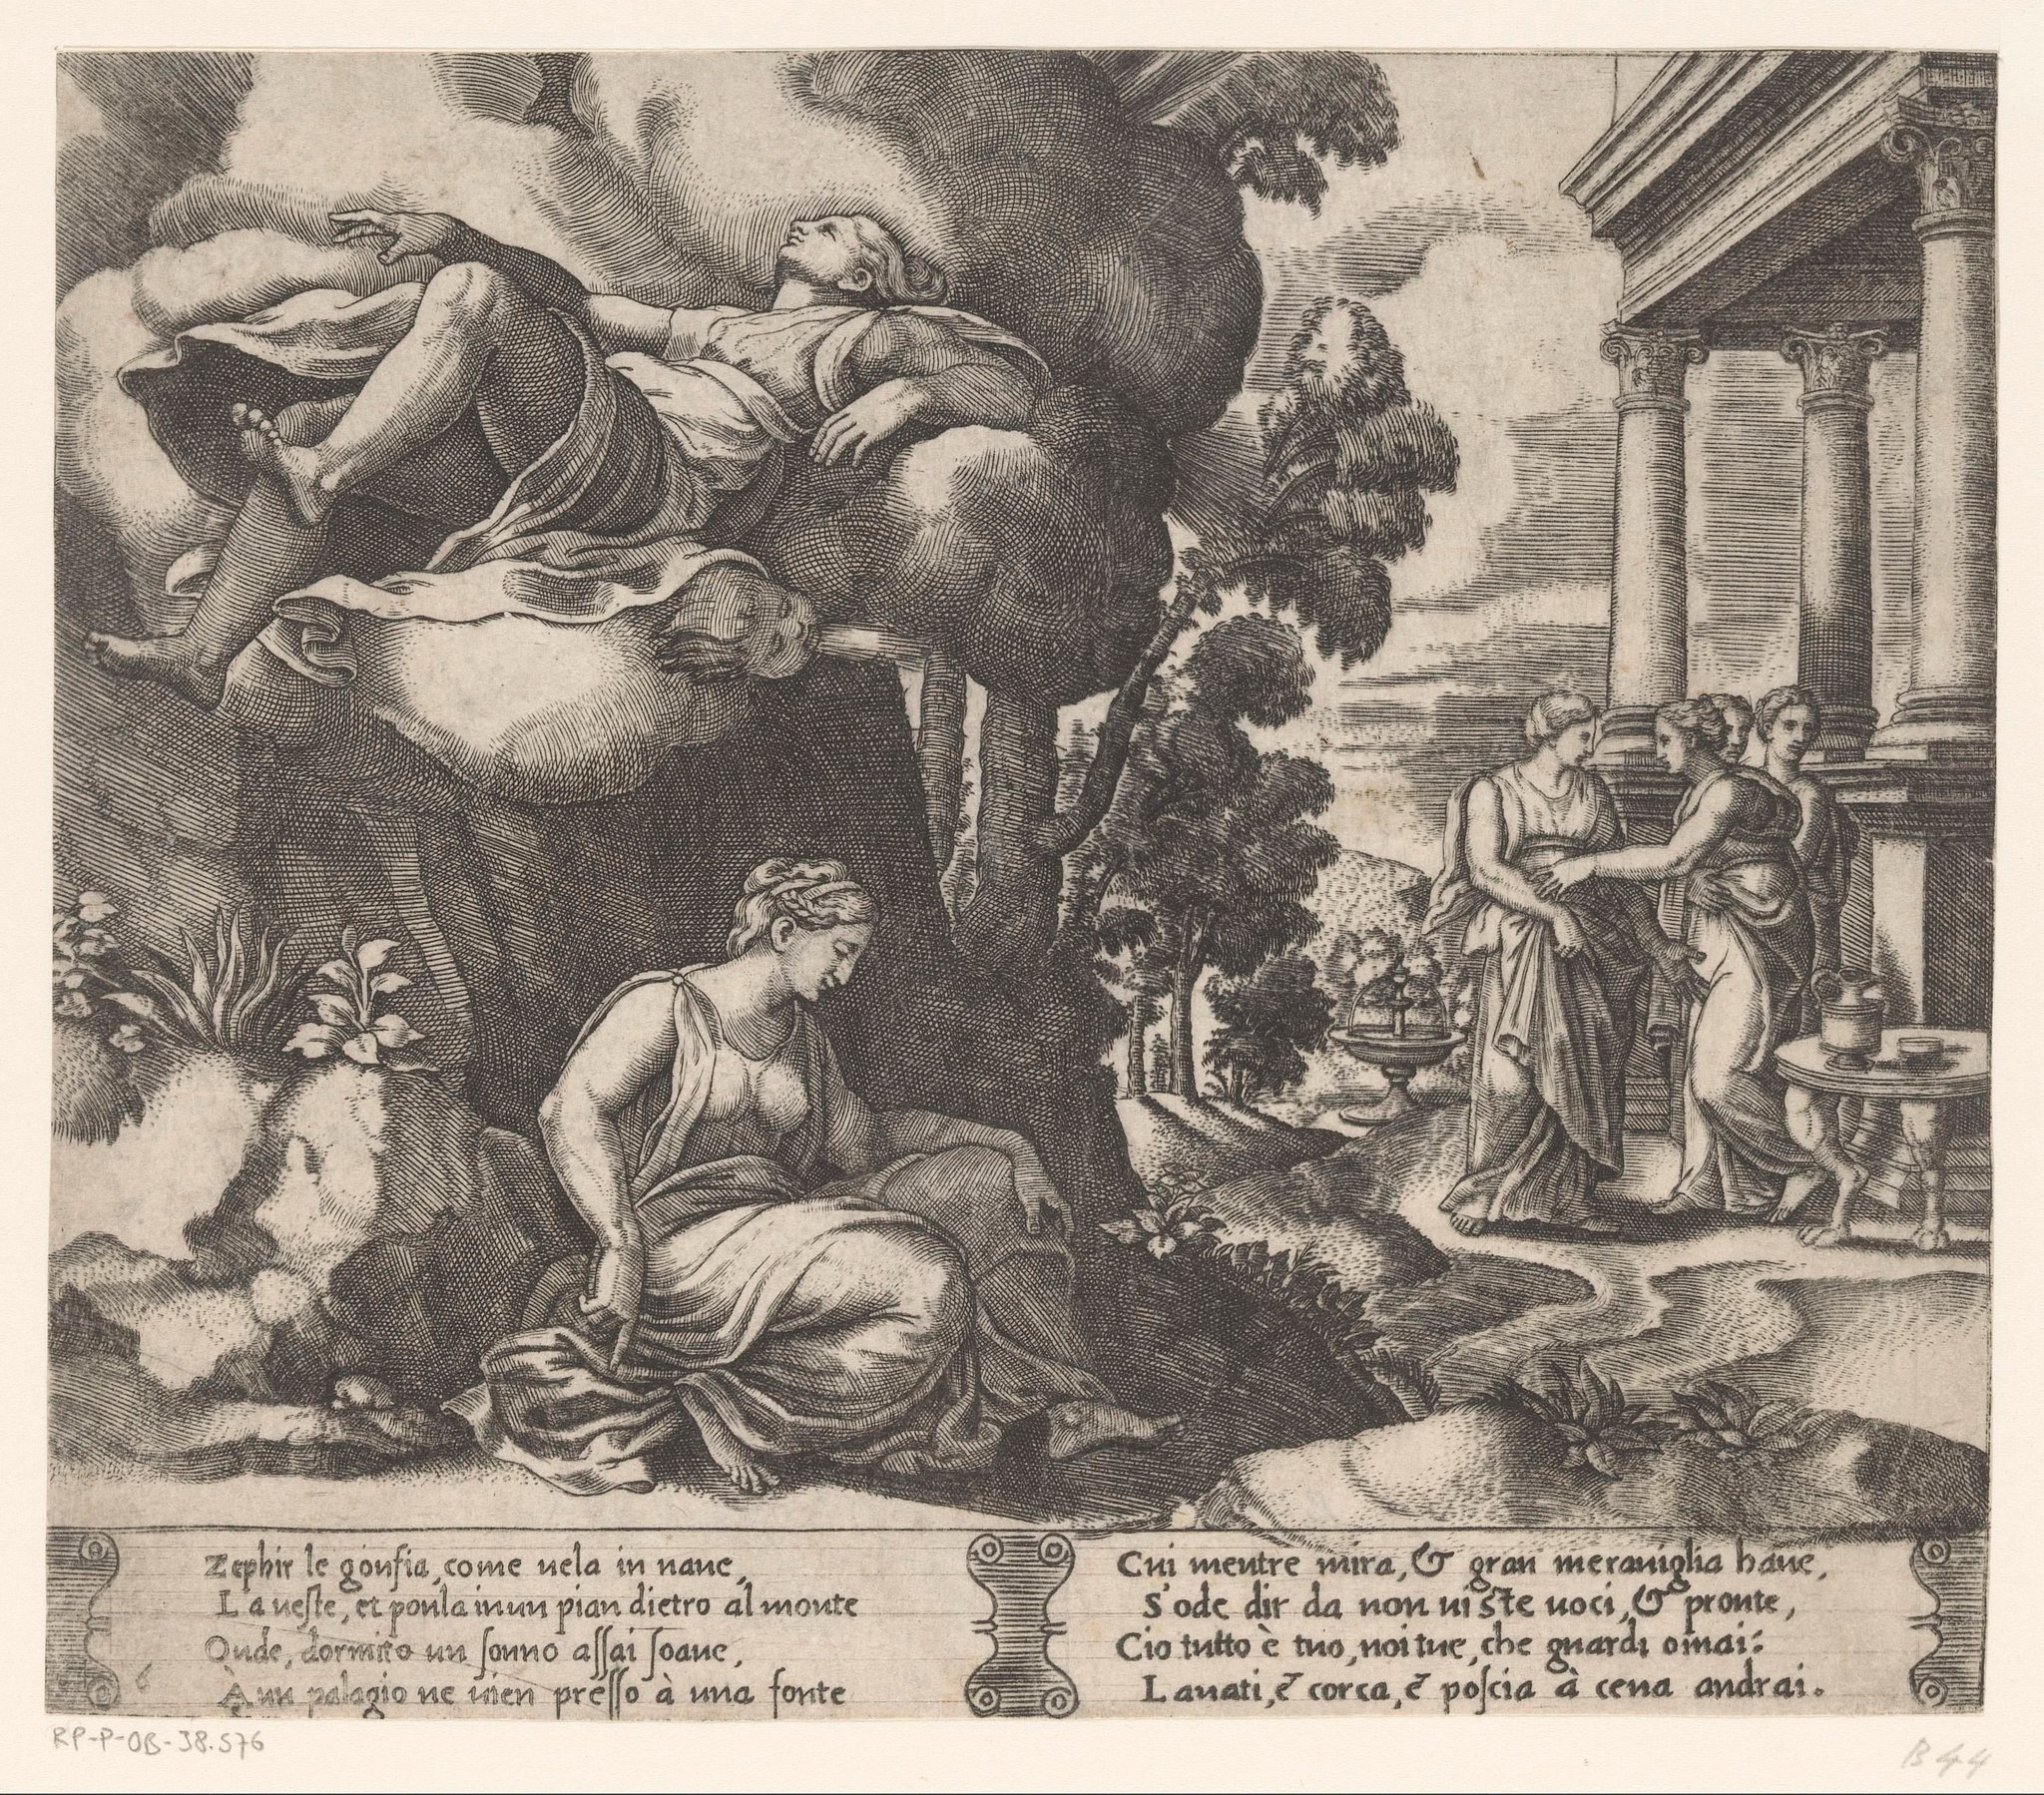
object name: print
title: Psyche meegevoerd door Zephyrus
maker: meester van de dobbelsteen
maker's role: print maker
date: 1530-1560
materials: paper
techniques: engraving, intaglio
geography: italy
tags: zephyrus carries psyche away, psyche falls asleep in a meadow; when she awakes she discovers cupid's palace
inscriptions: collector's mark: Lugt 2228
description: Psyche wordt tijdens haar slaap meegevoerd door Zephyrus (de personificatie van de westenwind). Rechts de aankomst van Psyche in het paleis van Amor. Italiaanse tekst in twee cartouches in ondermarge. Tweemaal genummerd linksonder: 6.